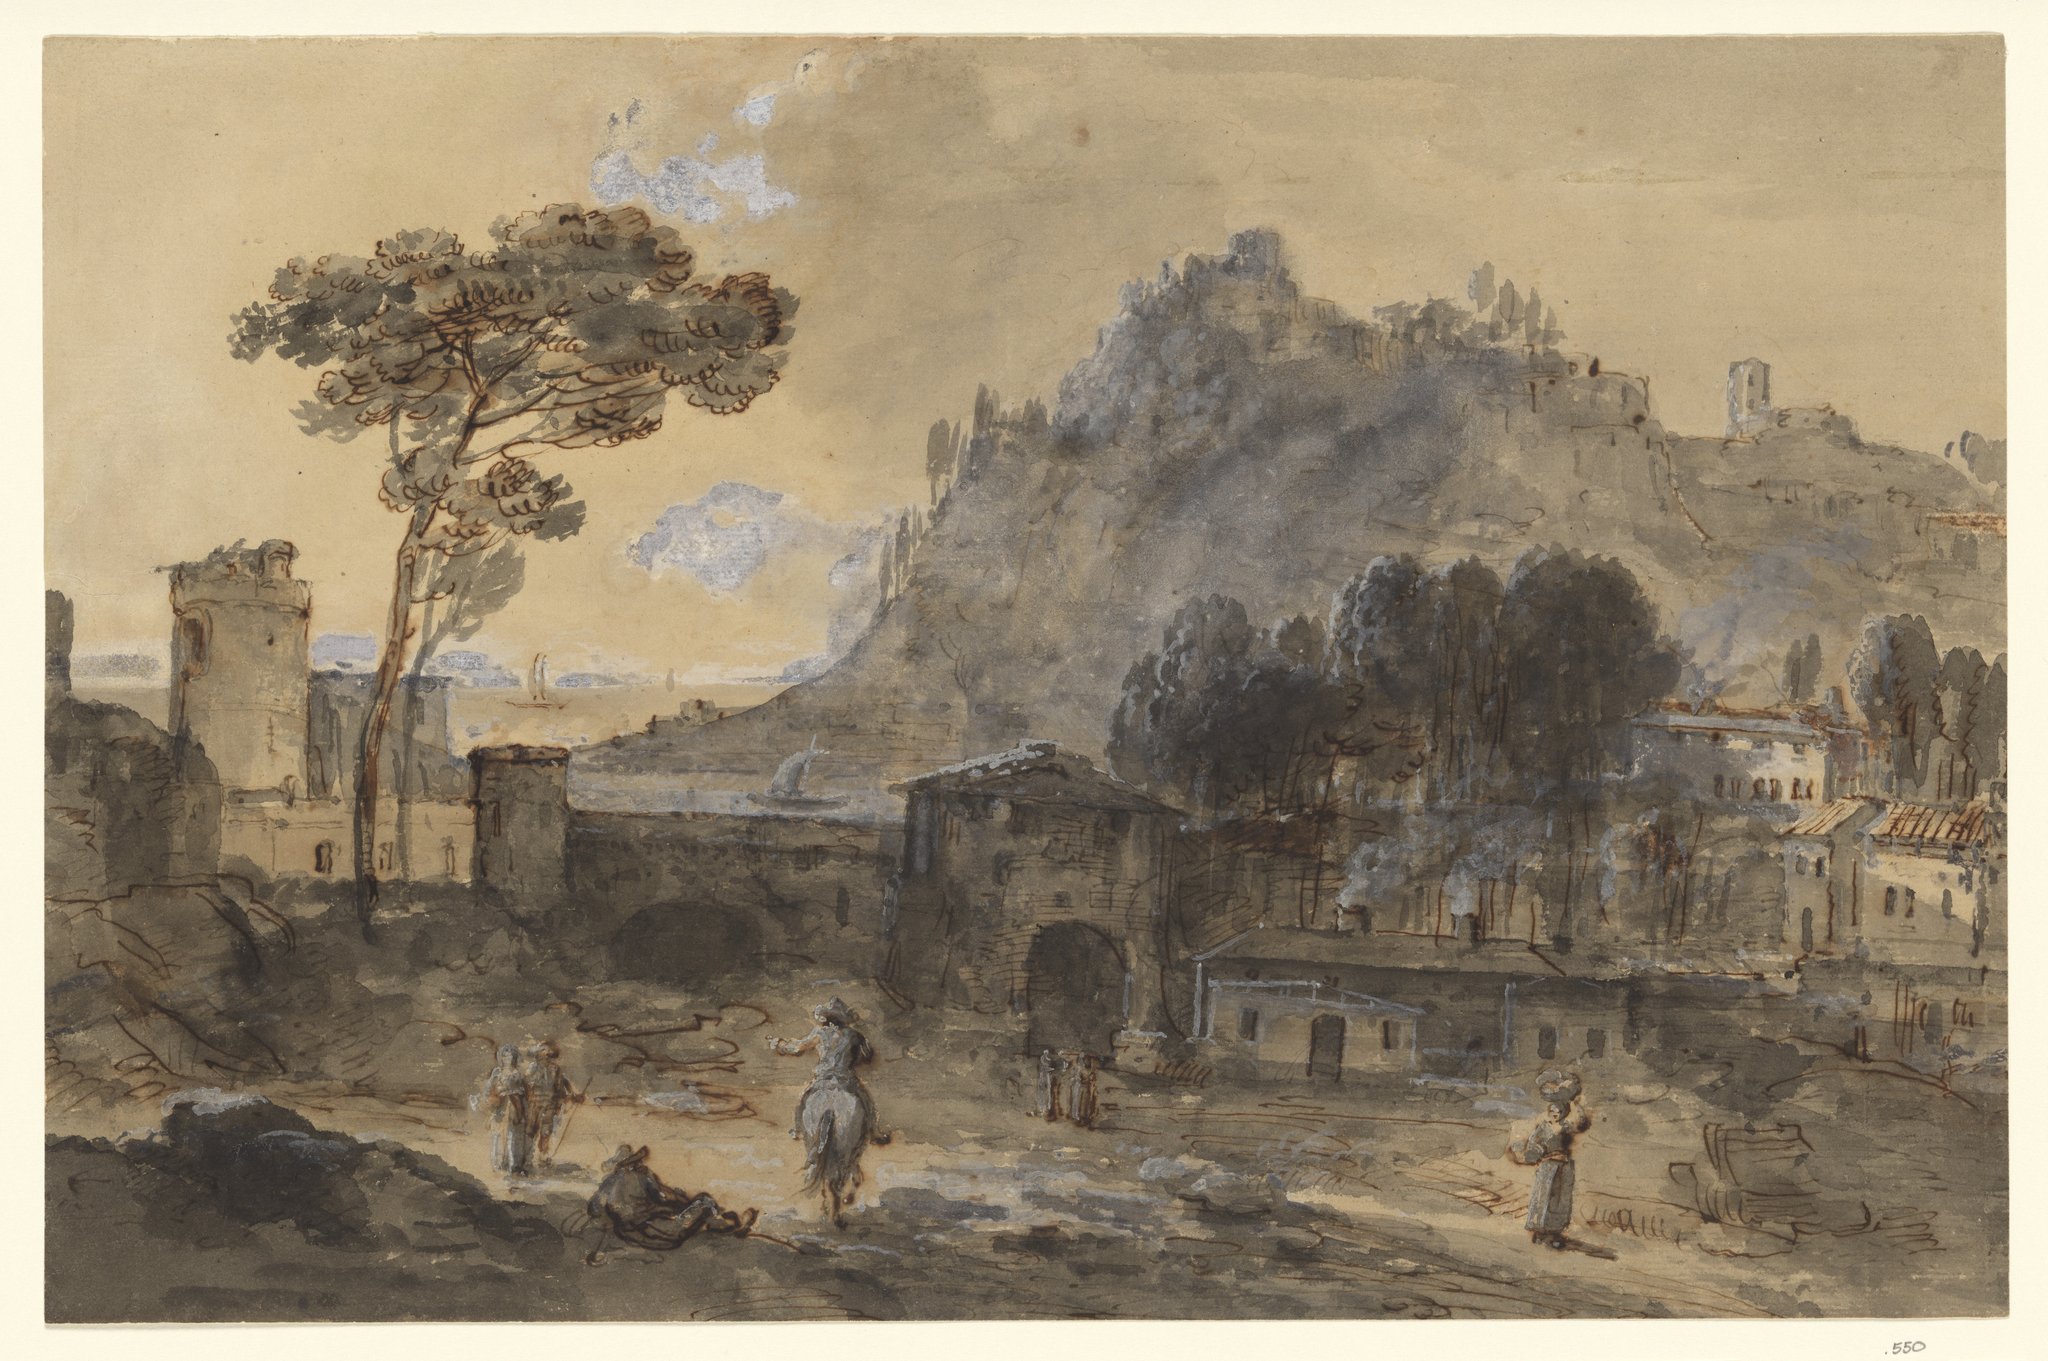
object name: drawing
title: Classical Landscape: A Town and a Mountain by the Coast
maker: francesco zuccarelli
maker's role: artist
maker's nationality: italian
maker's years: 1702-1788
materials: ink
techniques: heightening, pen, wash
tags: towns,landscapes